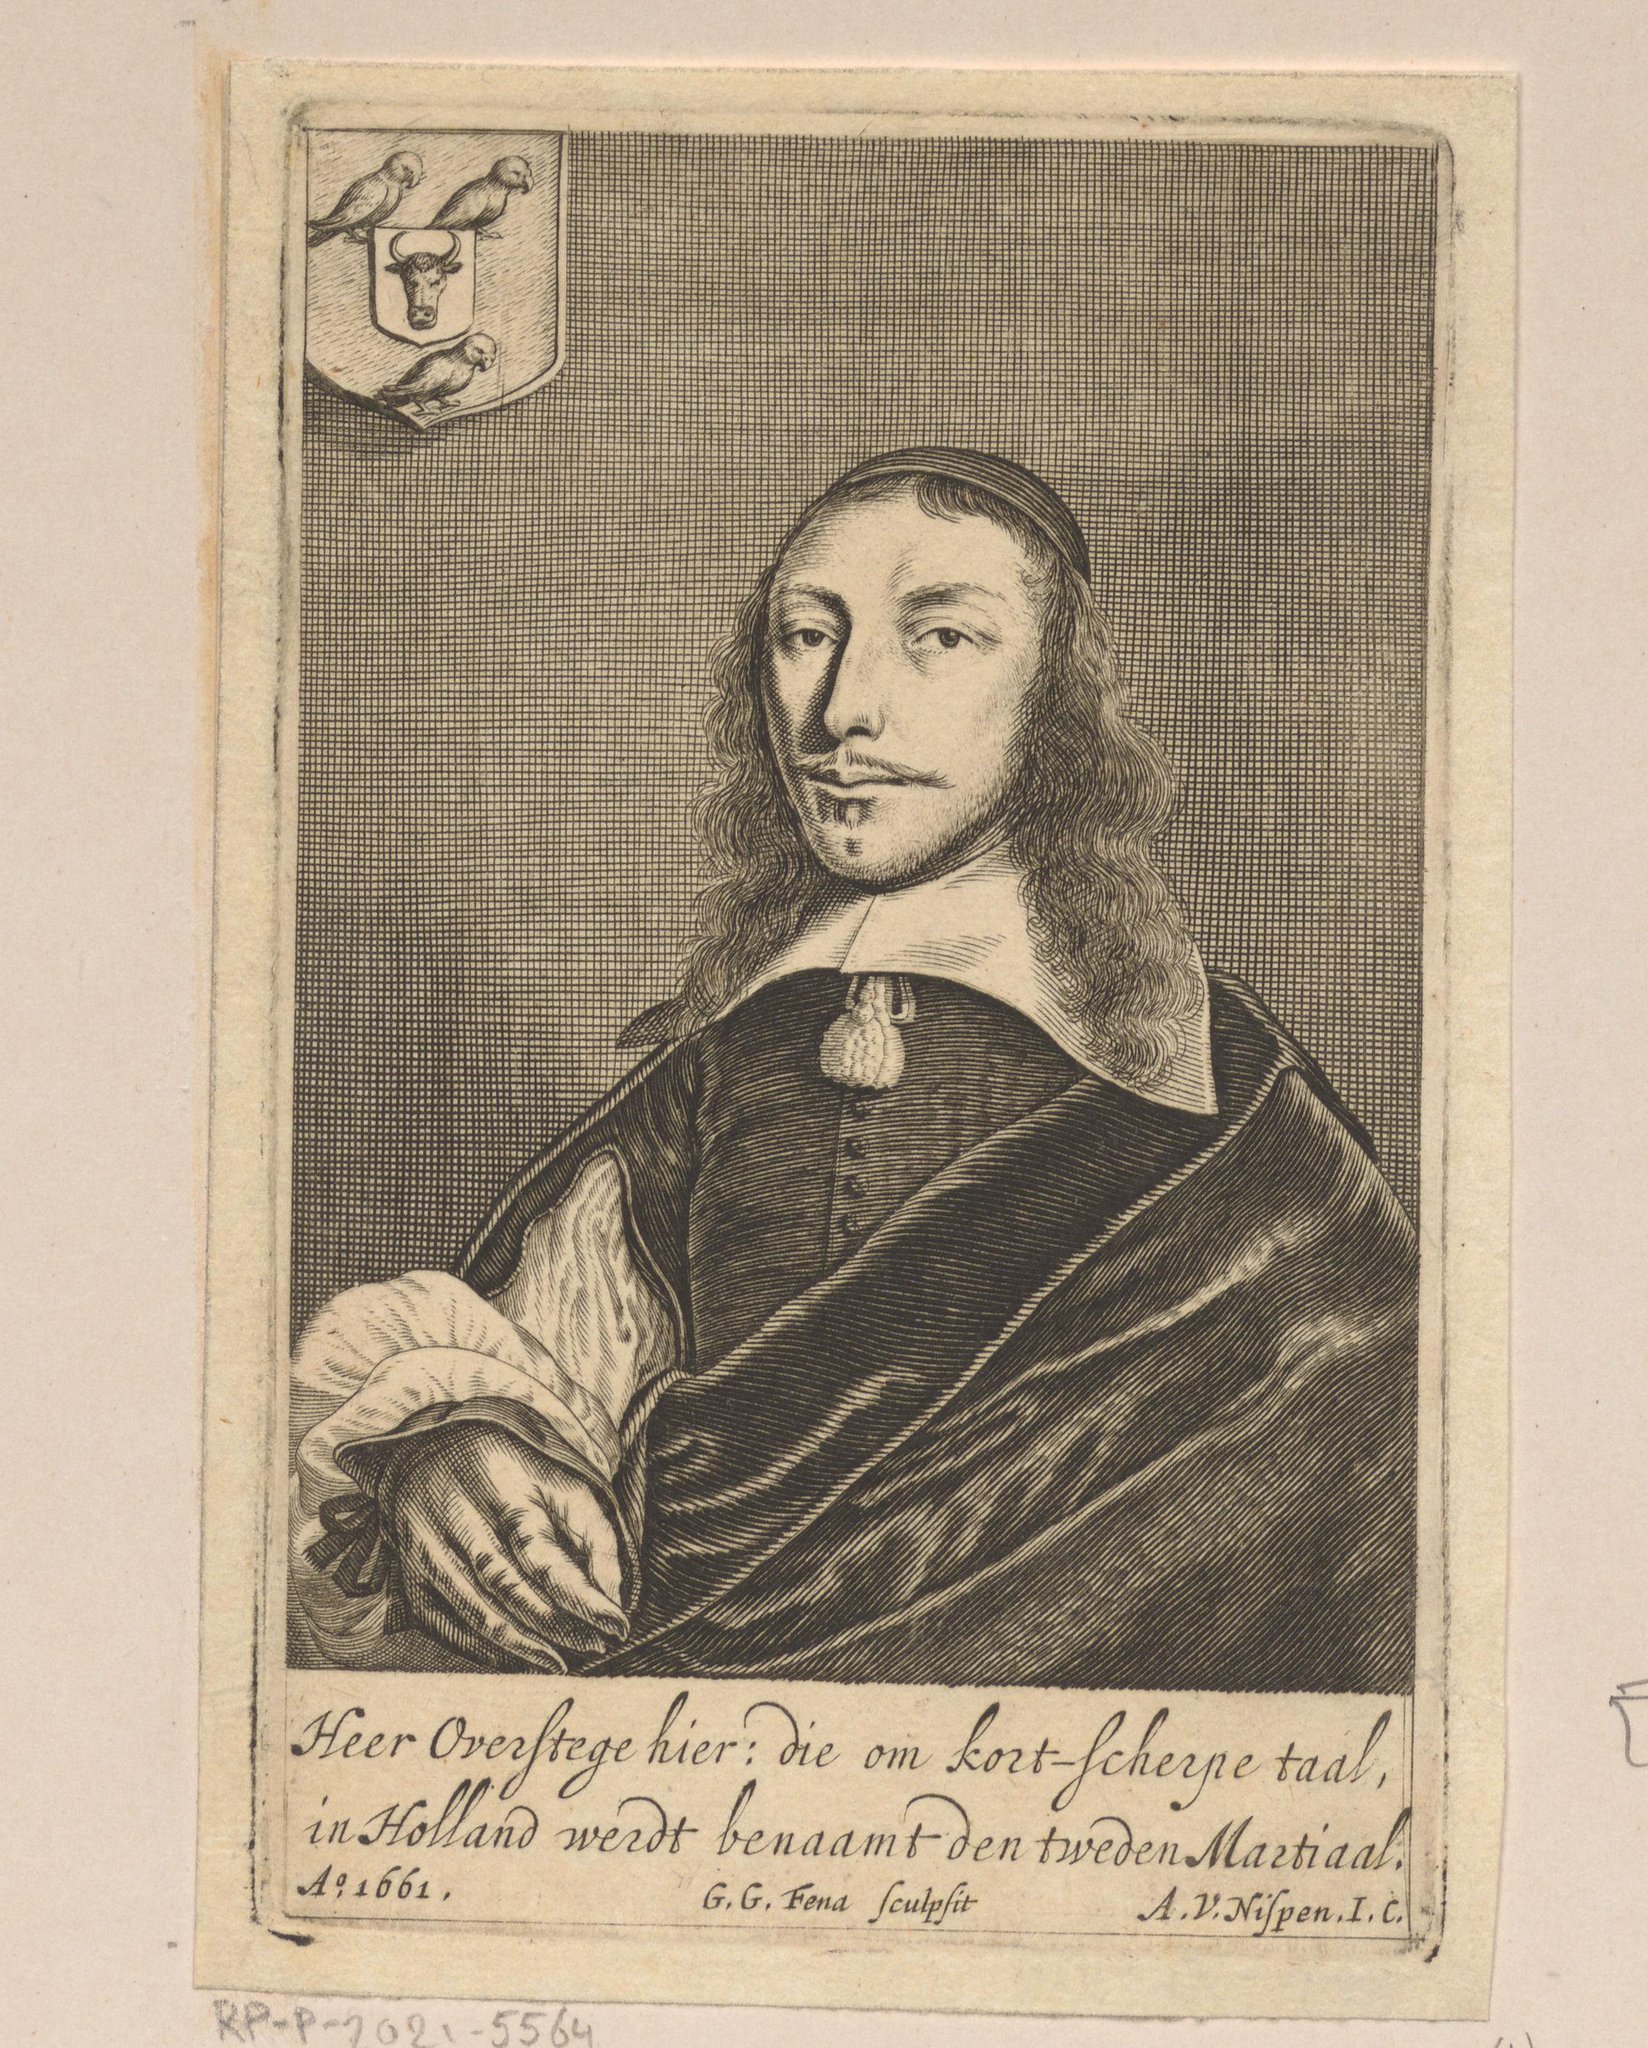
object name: print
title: Portret van Cornelis van Overstege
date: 1661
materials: paper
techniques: engraving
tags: historical persons, armorial bearing, heraldry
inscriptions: date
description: Boven het portret zijn wapenschild. Onder het portret een vierregelig vers.